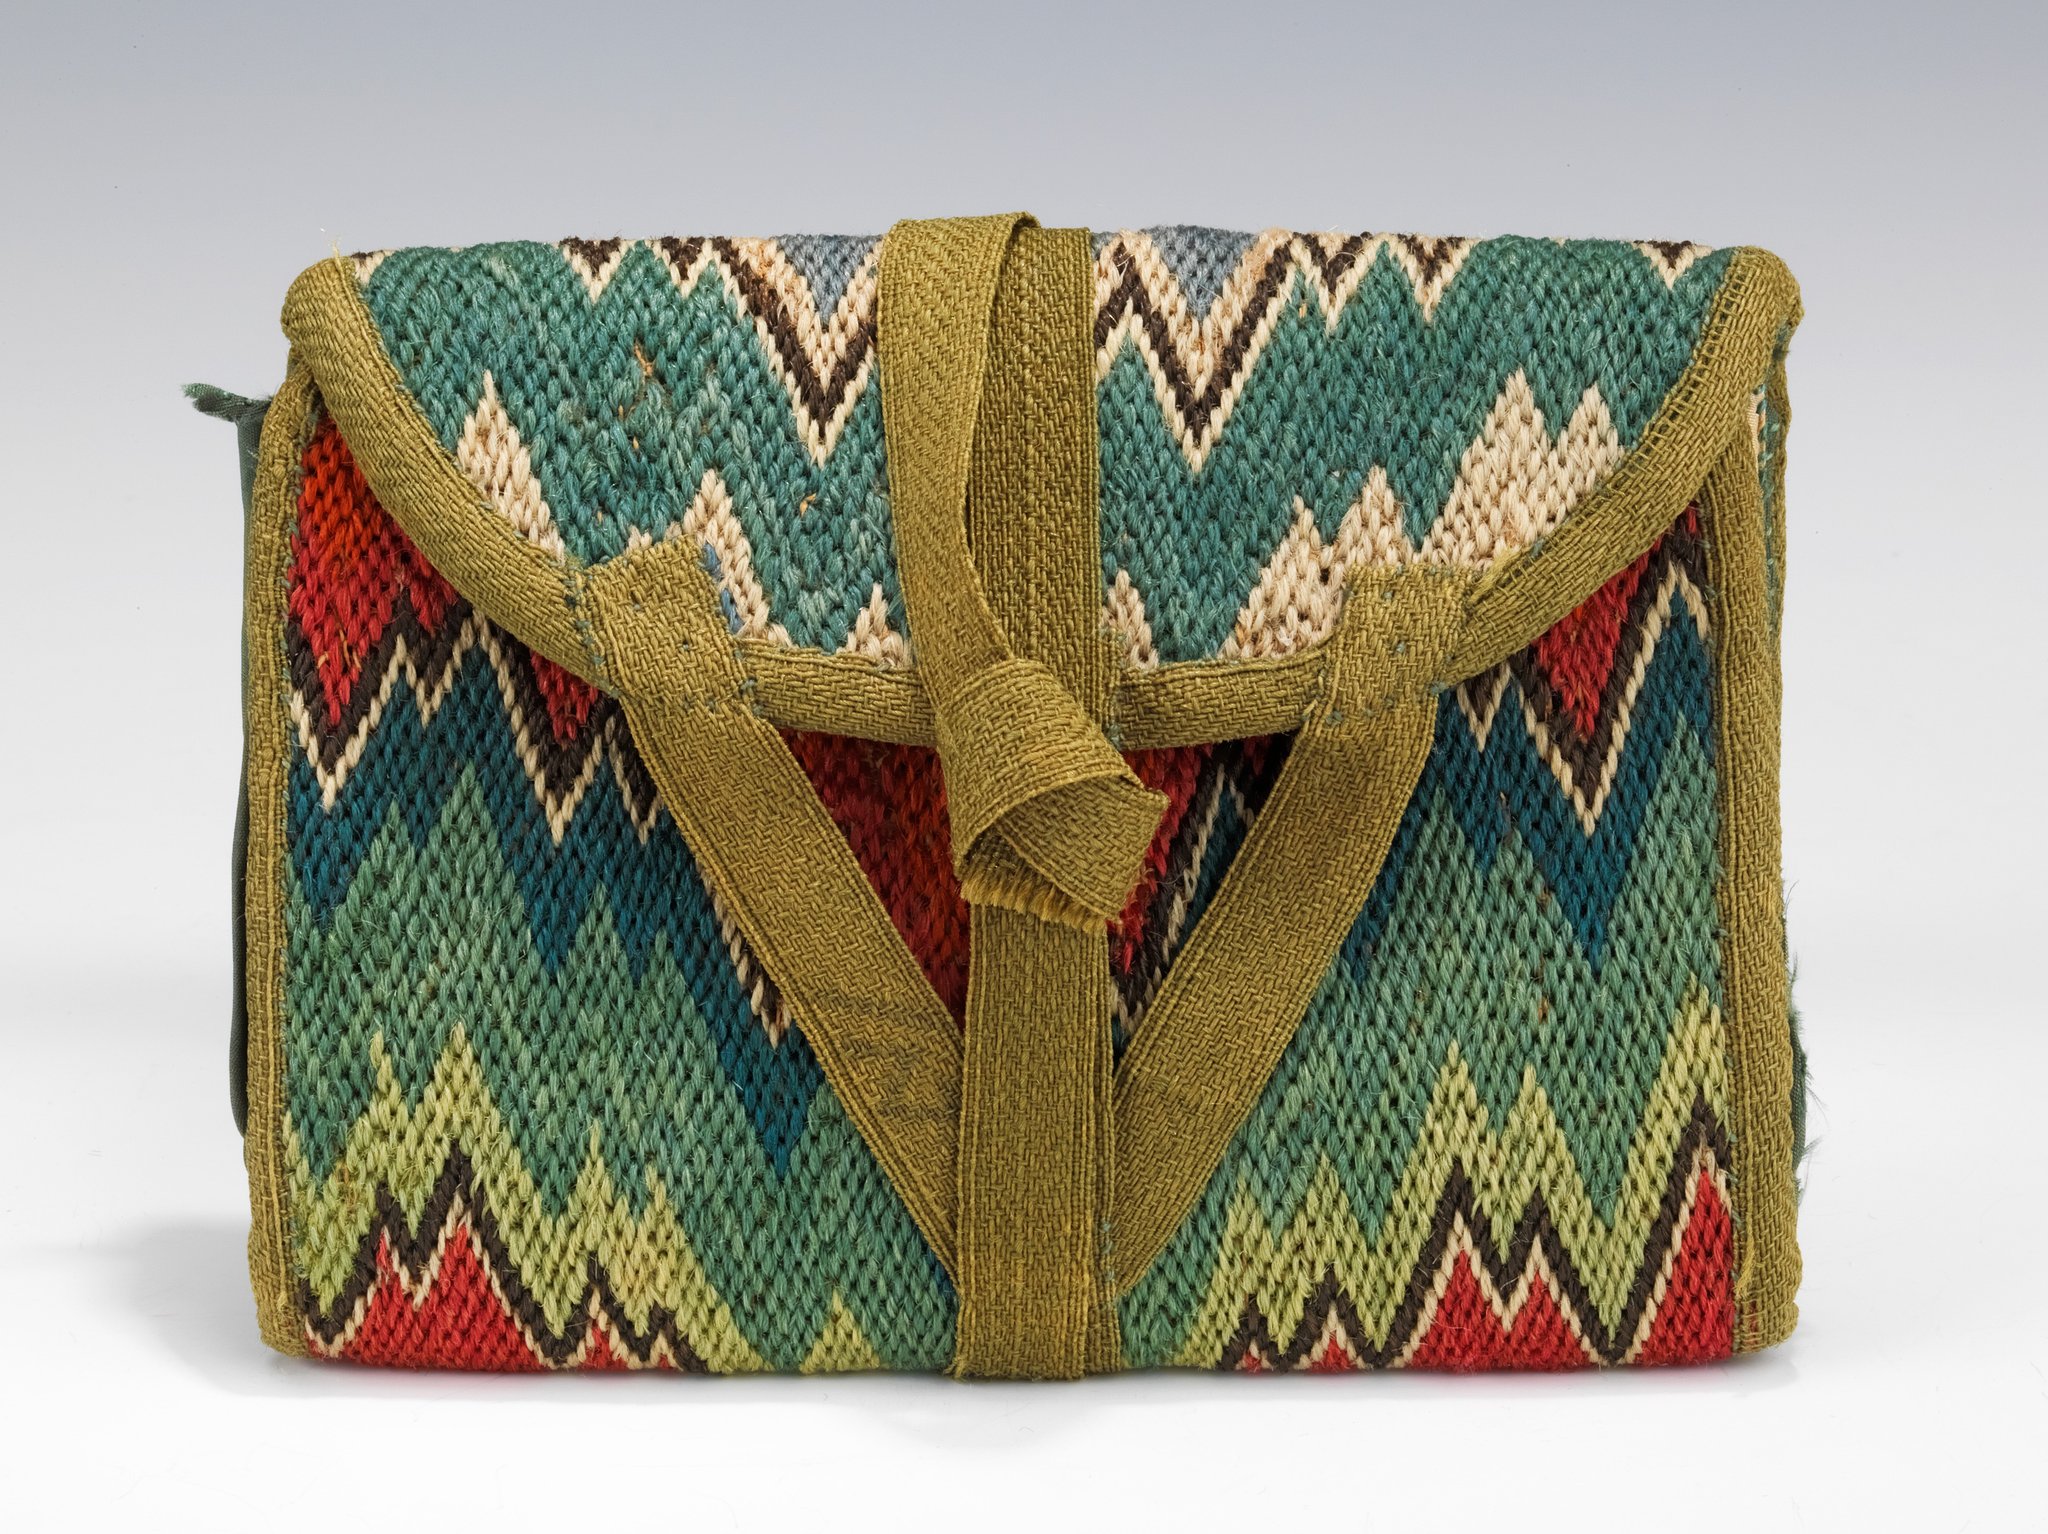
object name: purse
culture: american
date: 1790-1810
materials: linen, paper, silk, wool